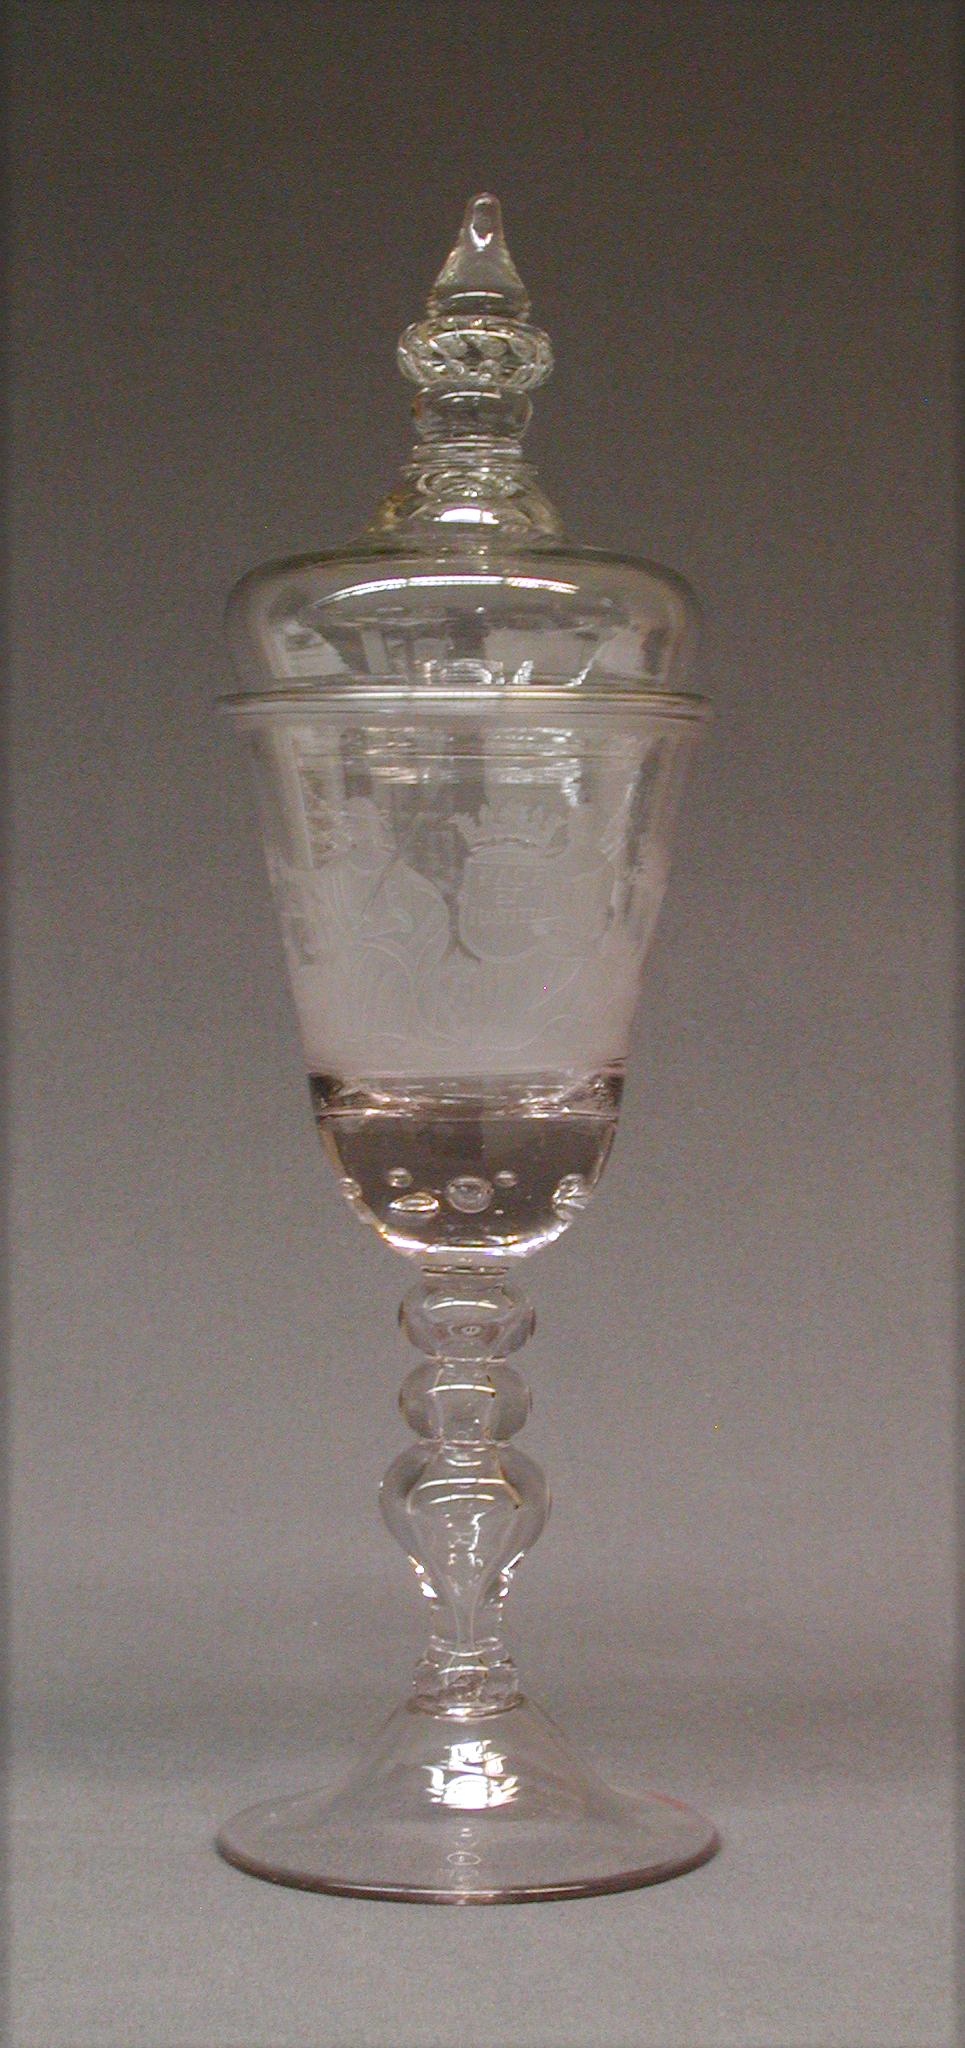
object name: wineglass with cover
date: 1701-1750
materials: glass